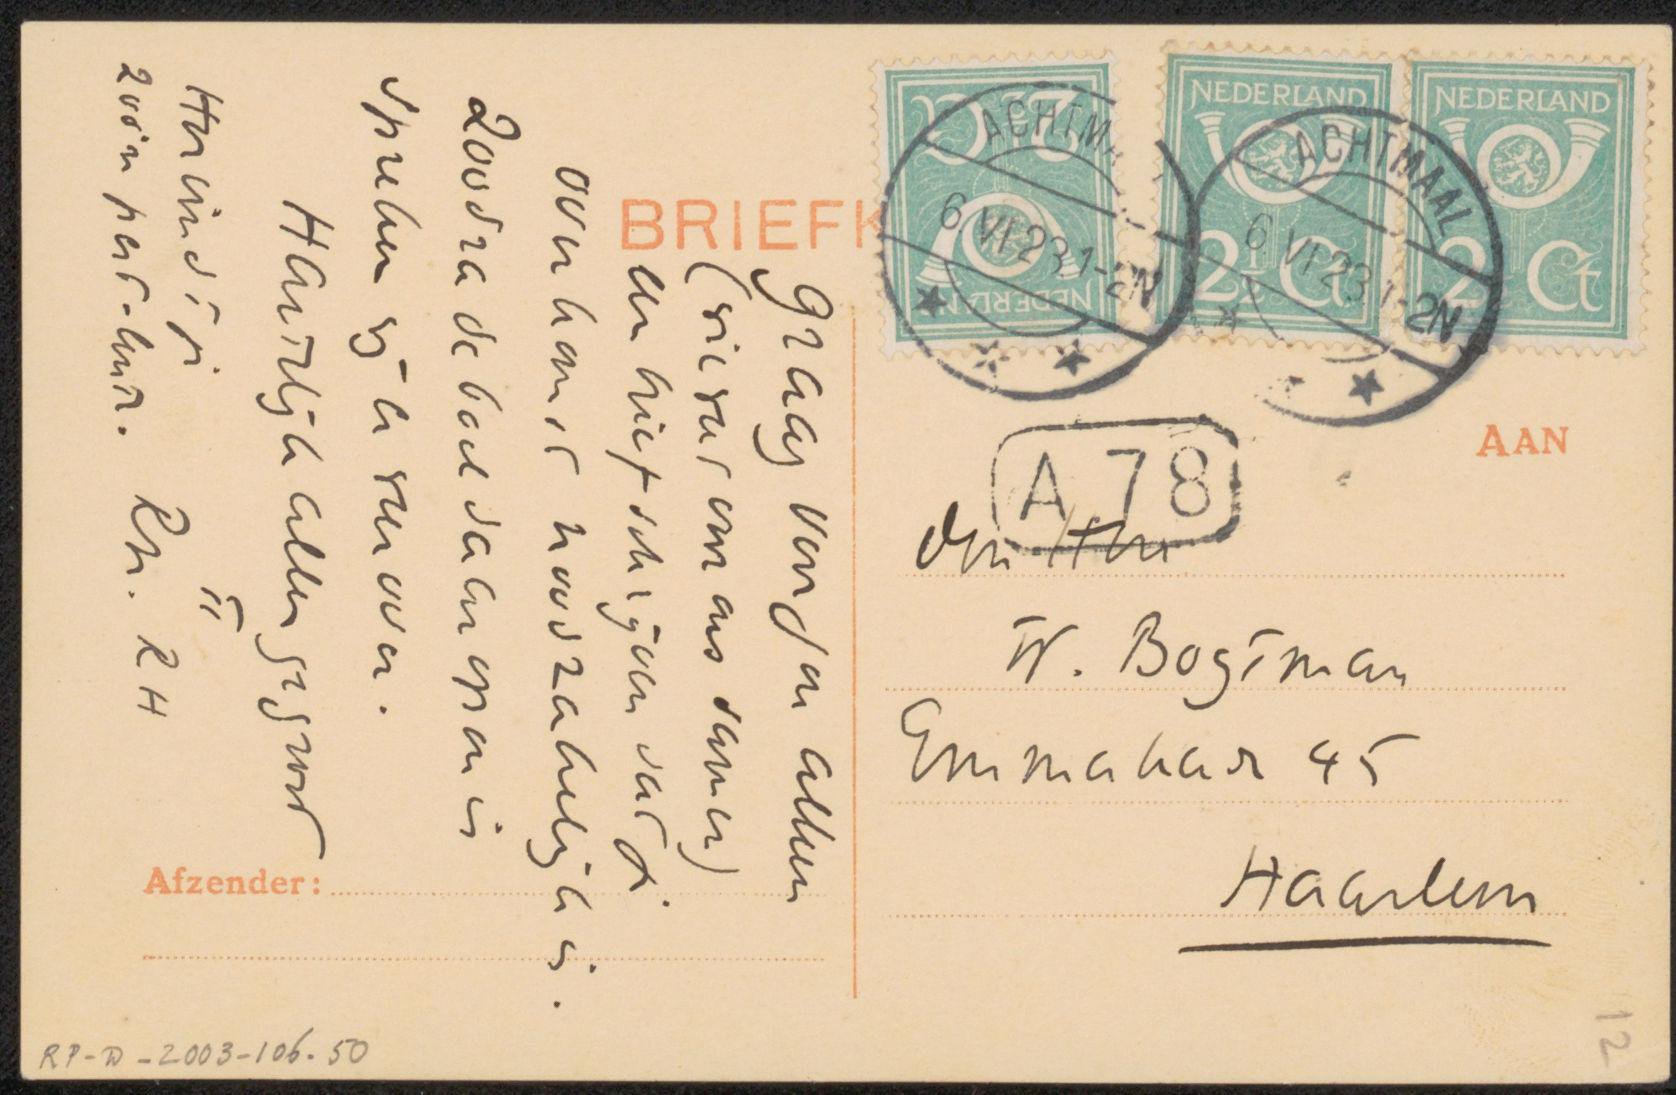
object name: postcard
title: Briefkaart aan Willem Bogtman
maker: richard nicolaüs roland holst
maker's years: 1868-1938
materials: cardboard, ink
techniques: pen, writing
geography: achtmaal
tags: willem bogtman